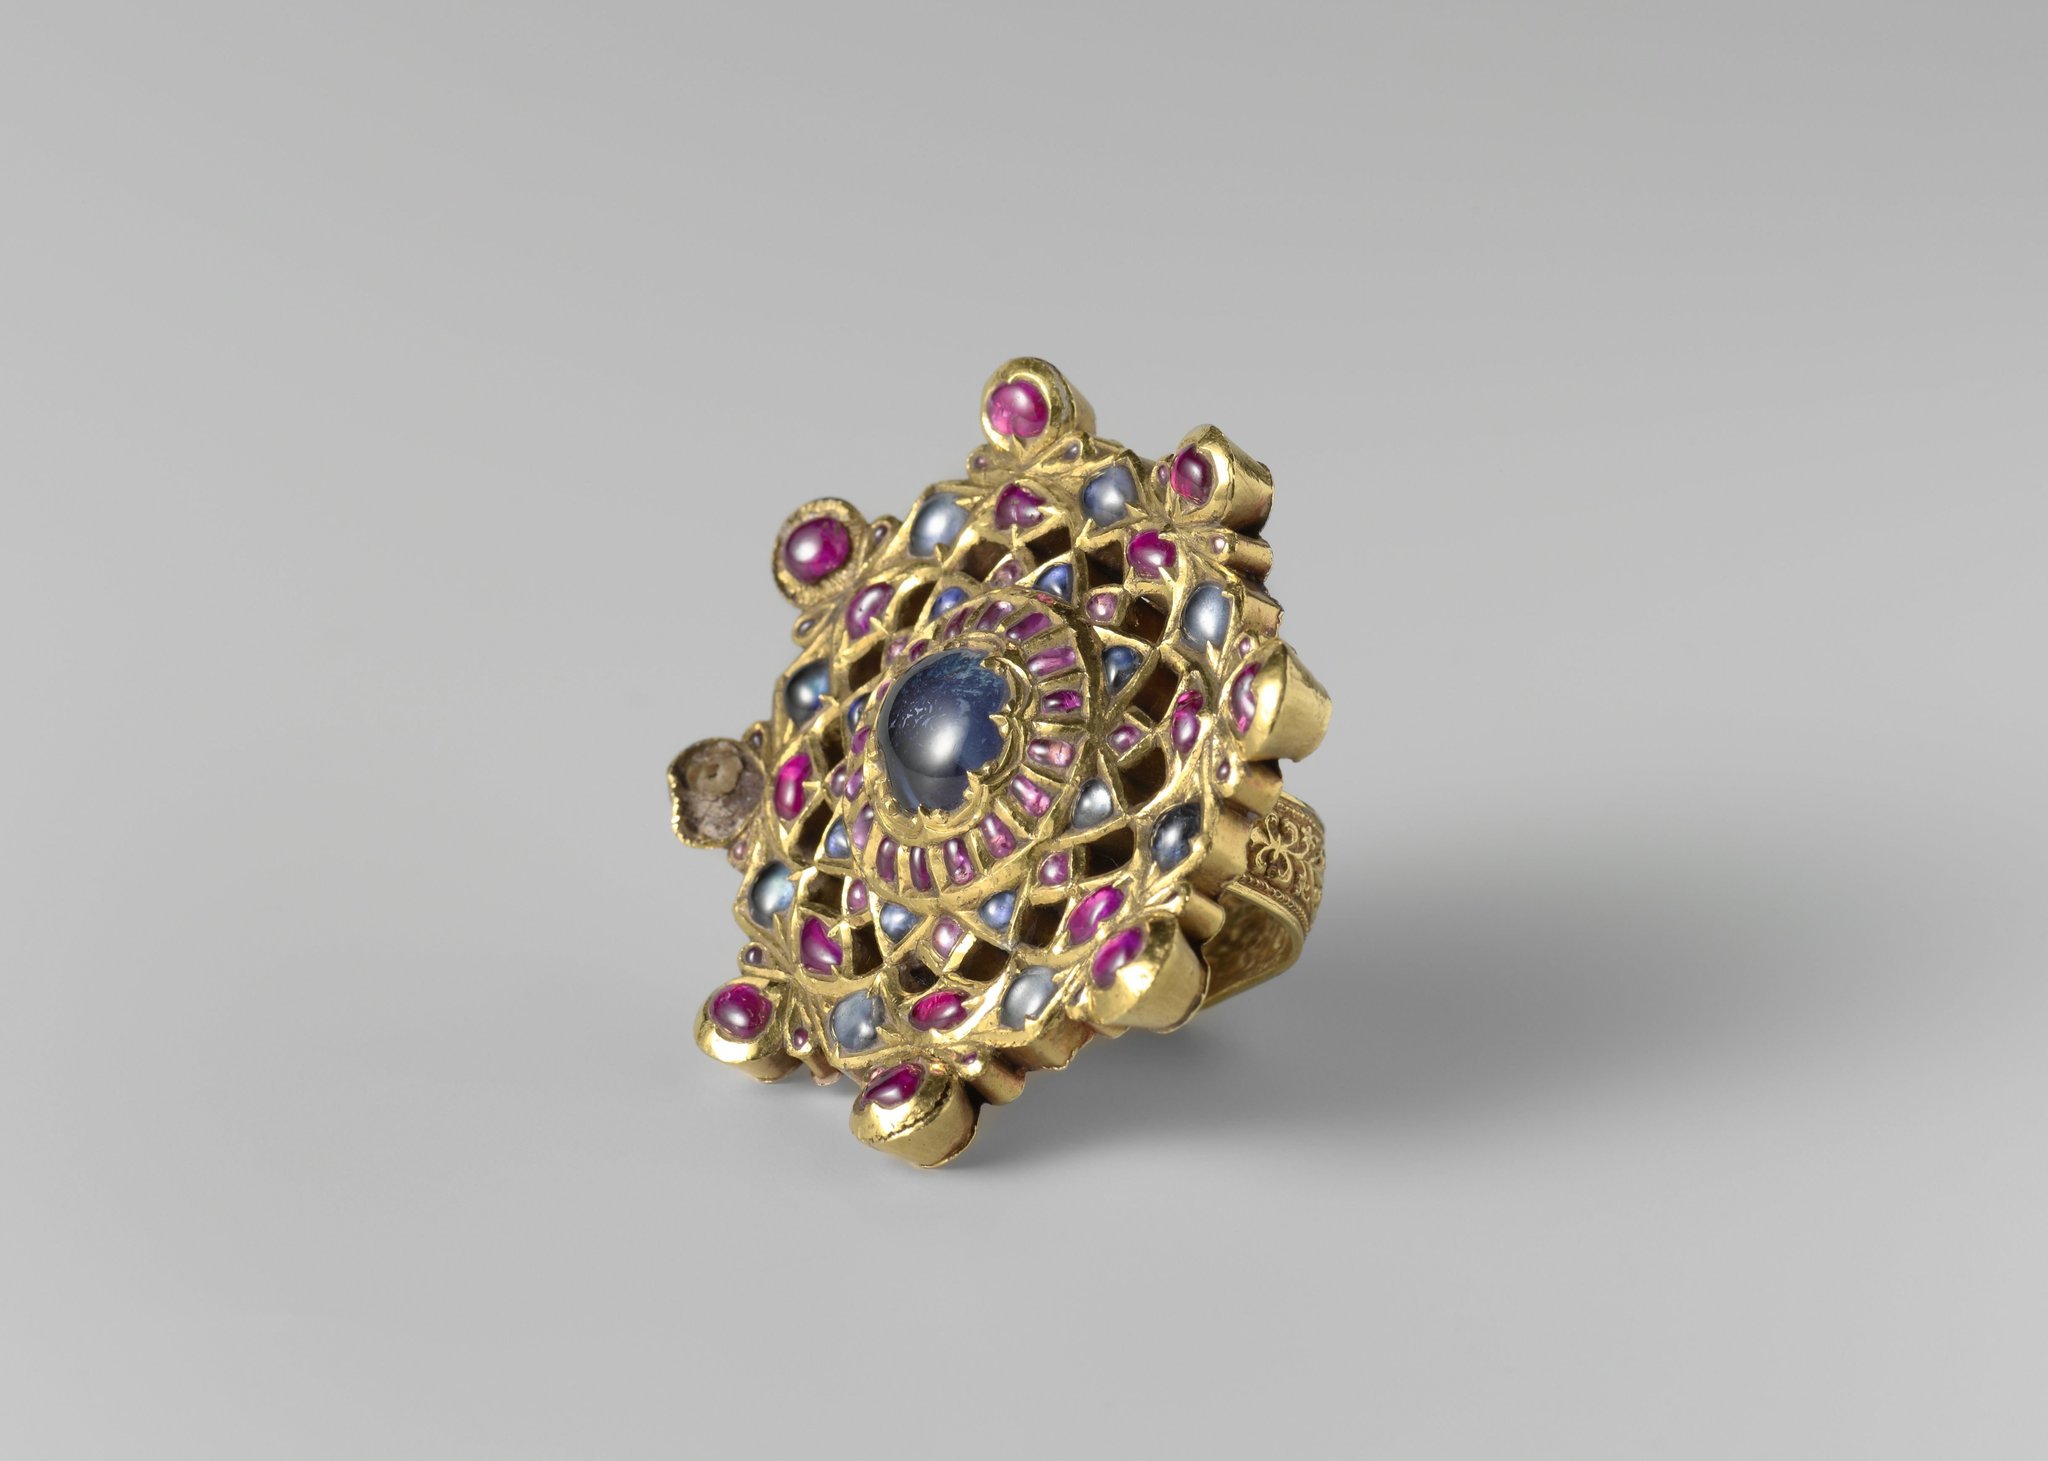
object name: jewellery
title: Ring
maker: Anonymous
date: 1750-1800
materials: gold, gemstone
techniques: filigree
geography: kandy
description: This kind of large rings was worn by the king and other dignitaries of Kandy. They were also presented as gifts, for instance, to European envoys seeking an audience with the king. This particular object could thus also have been a royal gift.